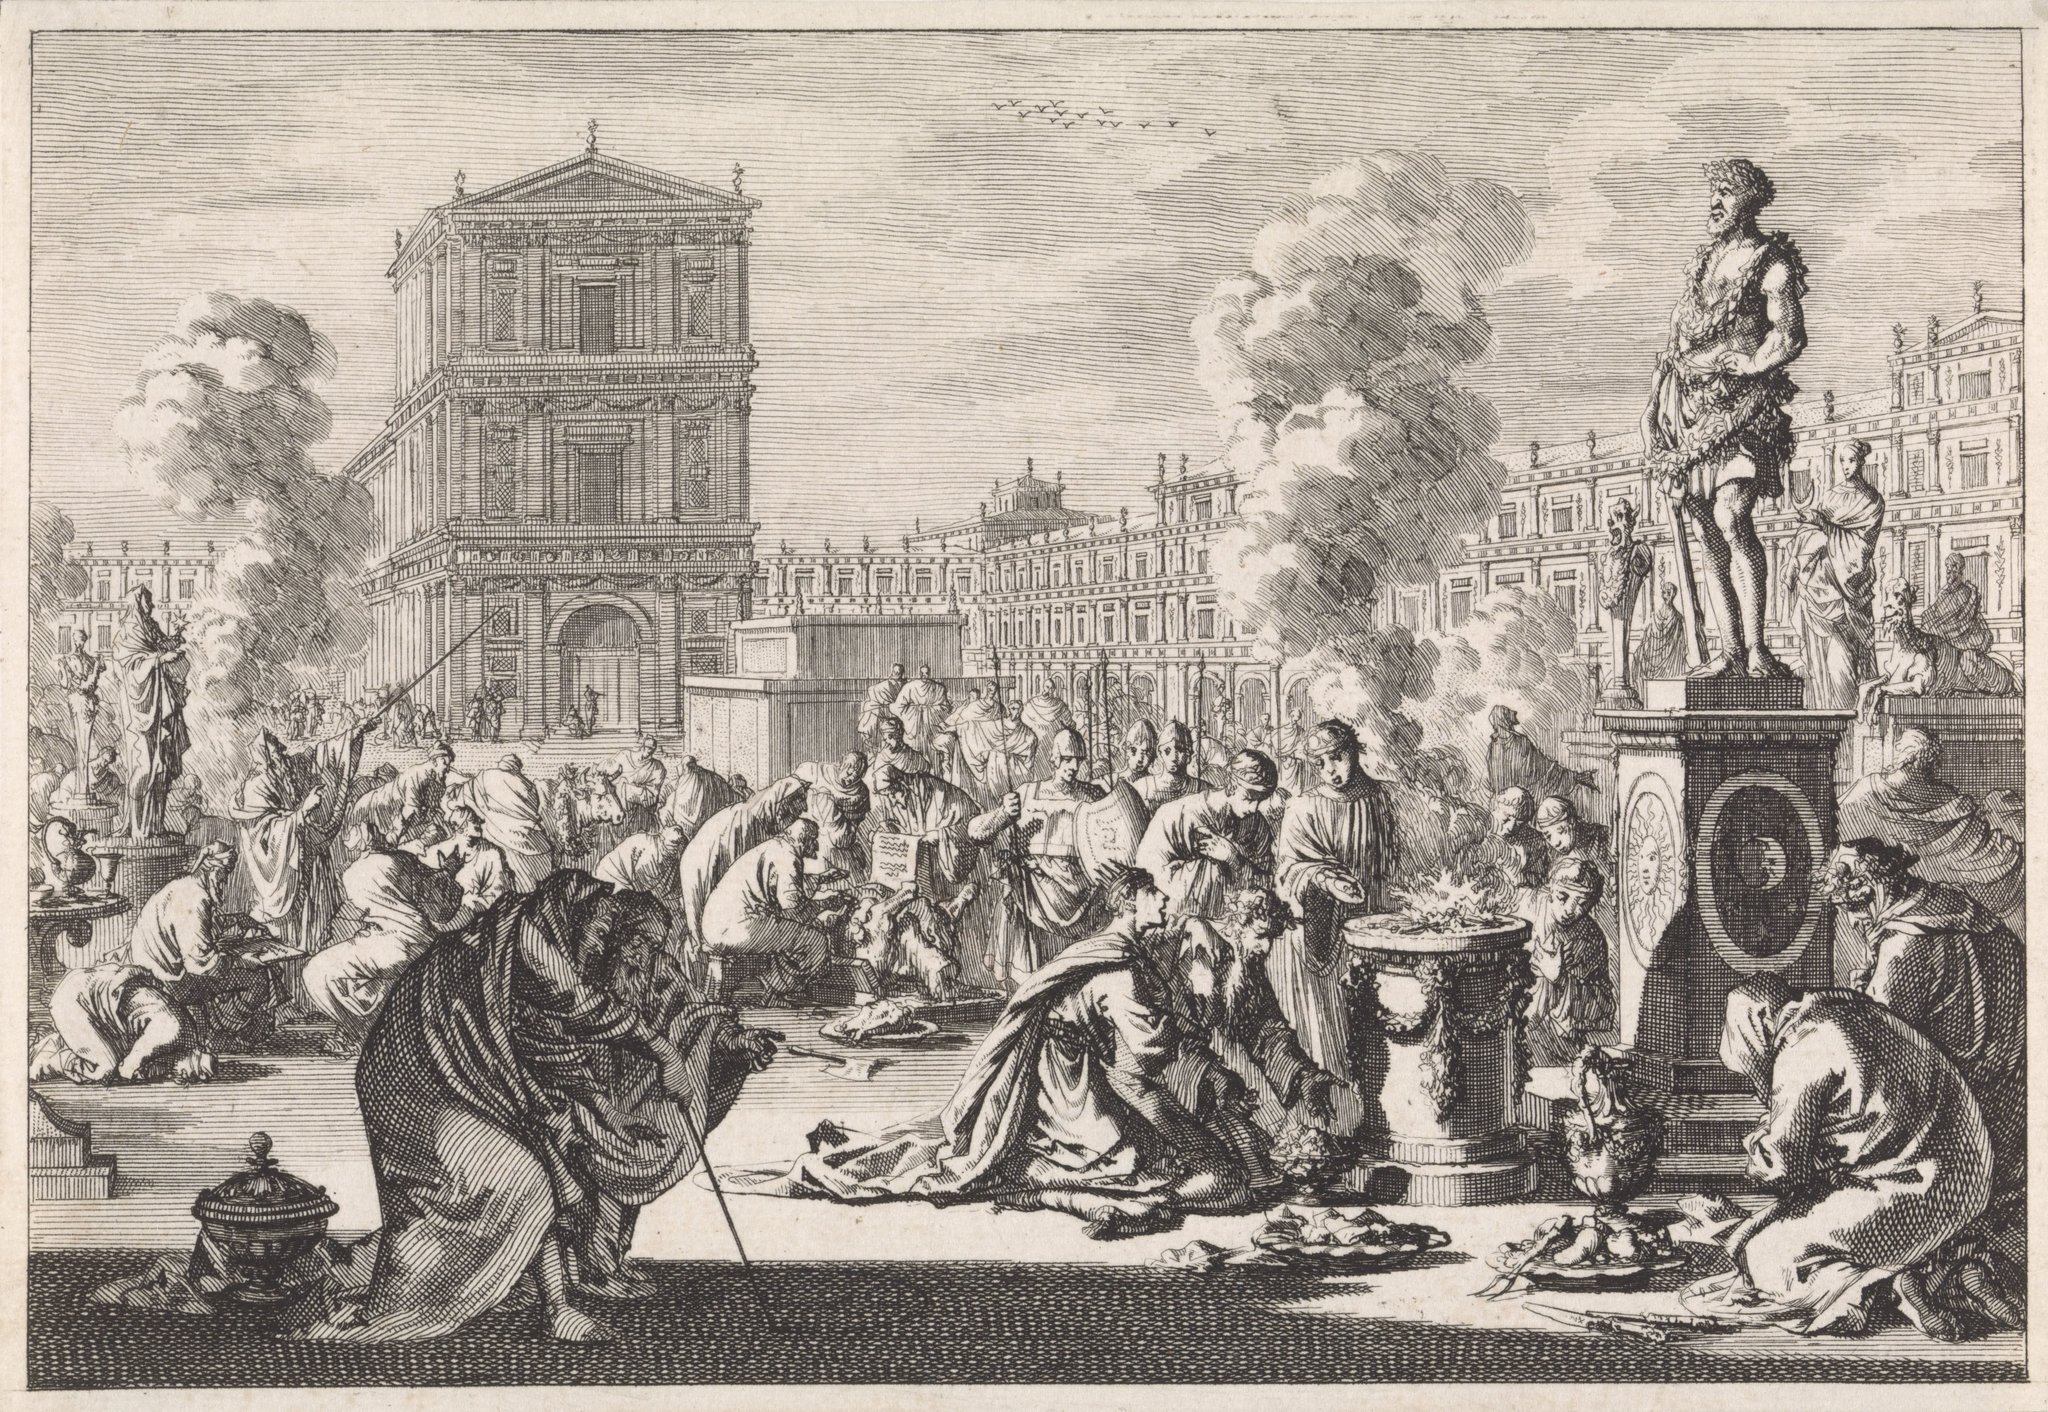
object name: print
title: Afgoderij van koning Manasse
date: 1700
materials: paper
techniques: etching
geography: amsterdam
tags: manasseh builds pagan altars in the temple of jerusalem and worships the stars, manasseh's apostasy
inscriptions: collector's mark: Lugt 2228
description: Proefdruk voor een boekillustratie voor David Martin. Historie des Ouden en Nieuwen Testaments, verrykt met meer dan vierhonderd printverbeeldingen. Amsterdam: Pieter Mortier, 1700.